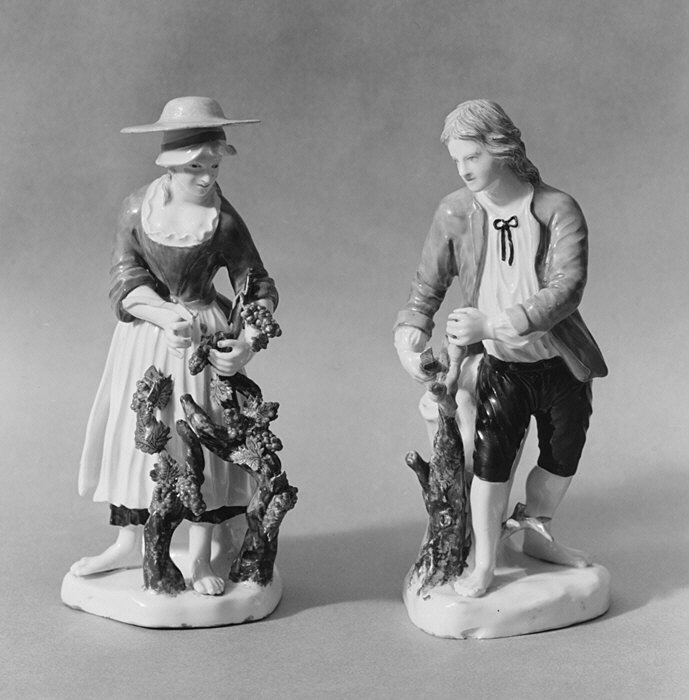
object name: figure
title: Gardener's companion (one of a pair)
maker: höchst manufactory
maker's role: manufactory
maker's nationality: german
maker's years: 1746-1796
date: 1750-1752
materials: hard paste porcelain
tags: men,women,gardeners